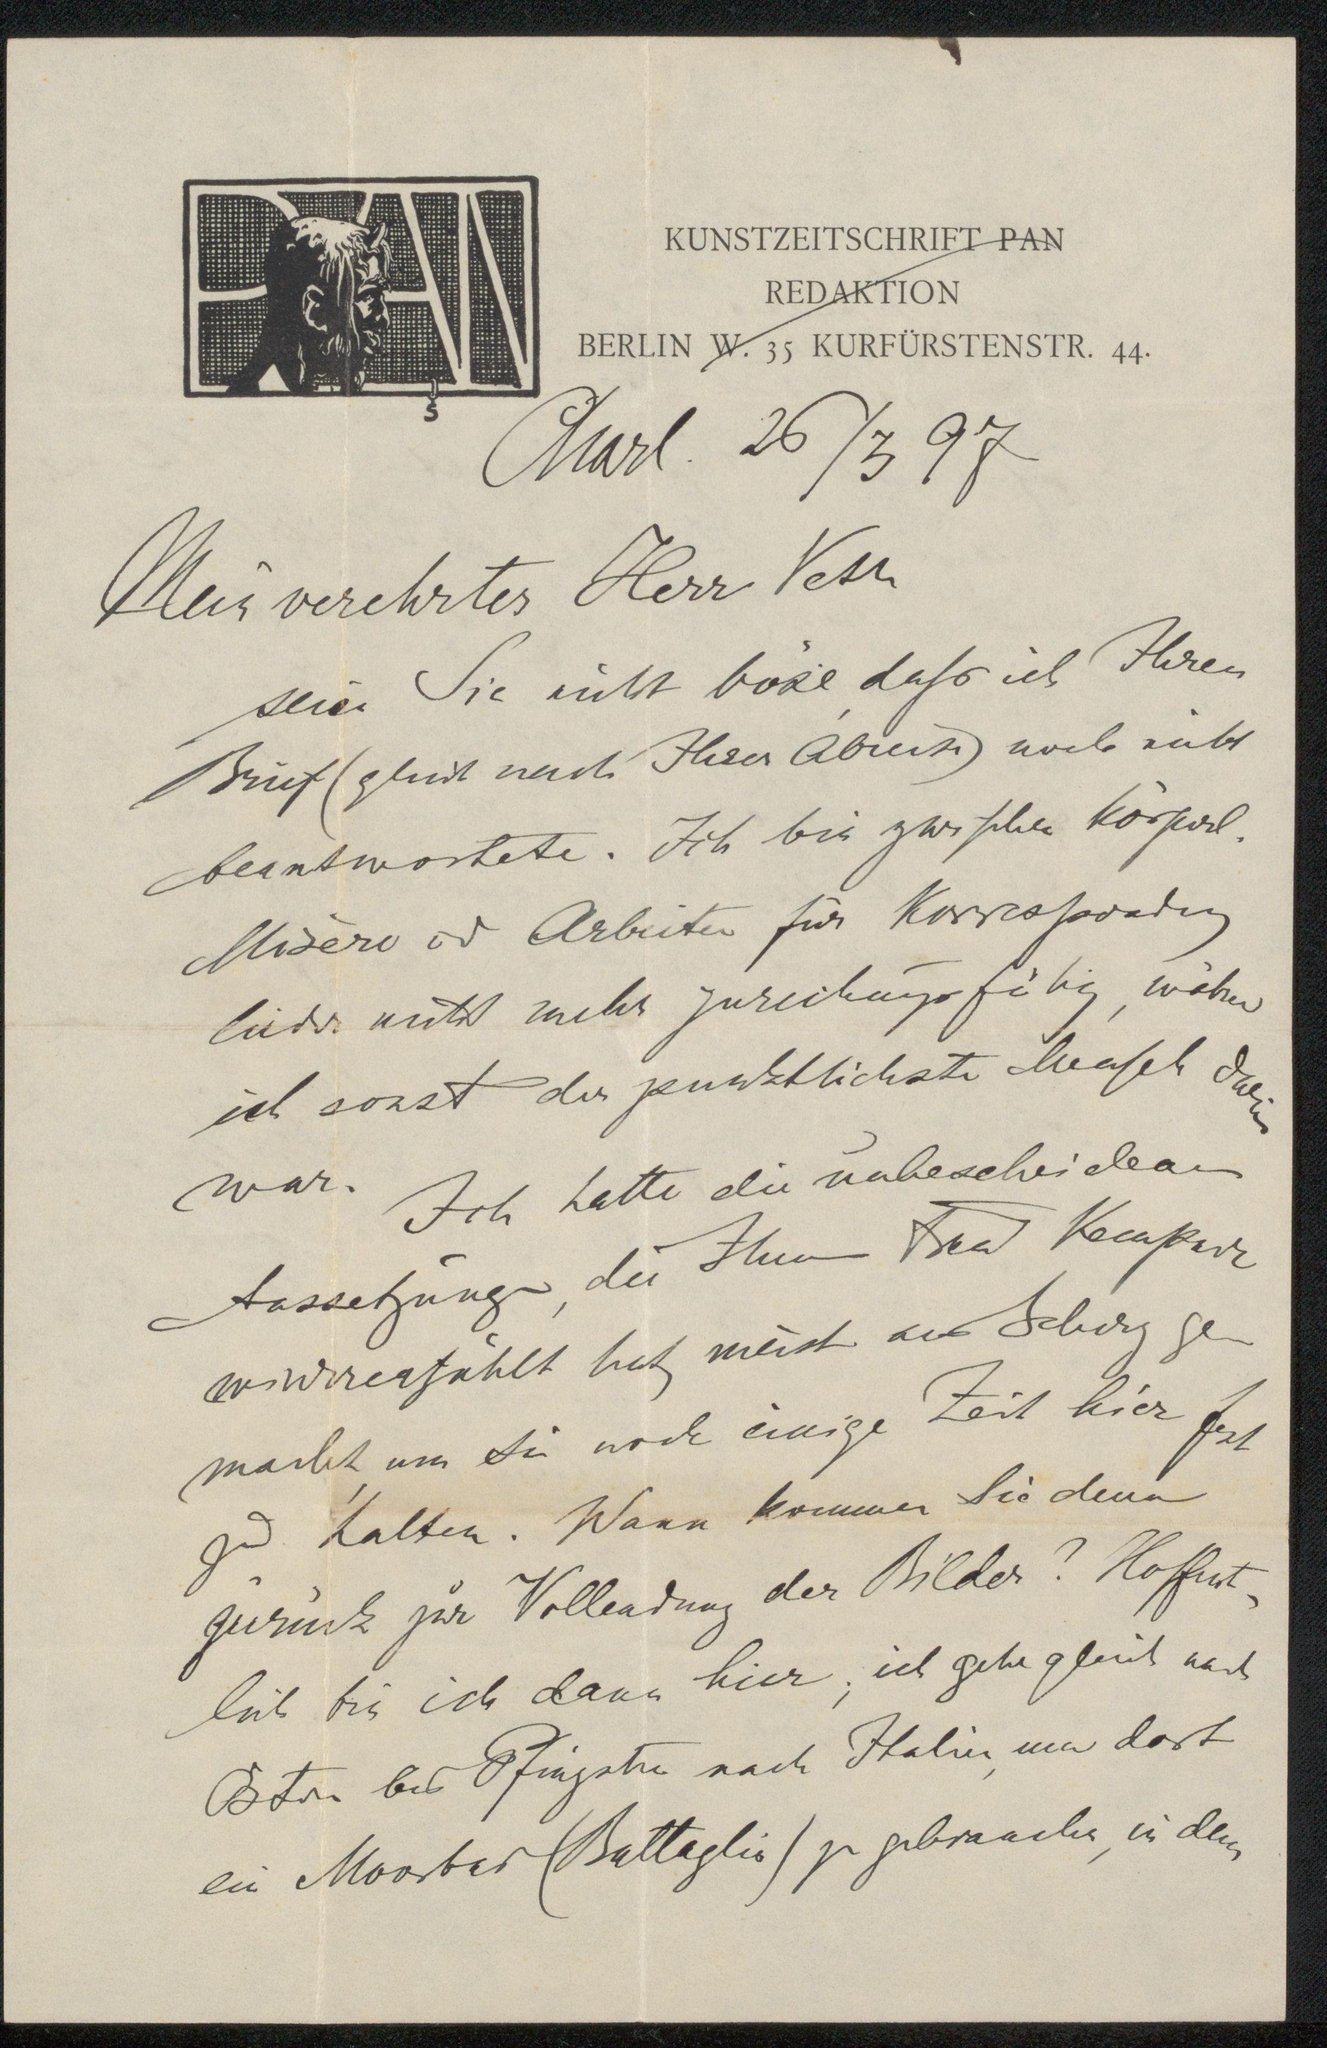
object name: letter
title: Brief aan Jan Veth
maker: wilhelm von bode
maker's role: conservator, kunsthistoricus, museumdirecteur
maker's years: 1845-1929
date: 1897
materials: ink, paper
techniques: pen, printing, writing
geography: charlottenburg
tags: dordrecht, amsterdam, painter, draughtsman, designer, jan veth, italy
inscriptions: collector's mark: ‘RPK’